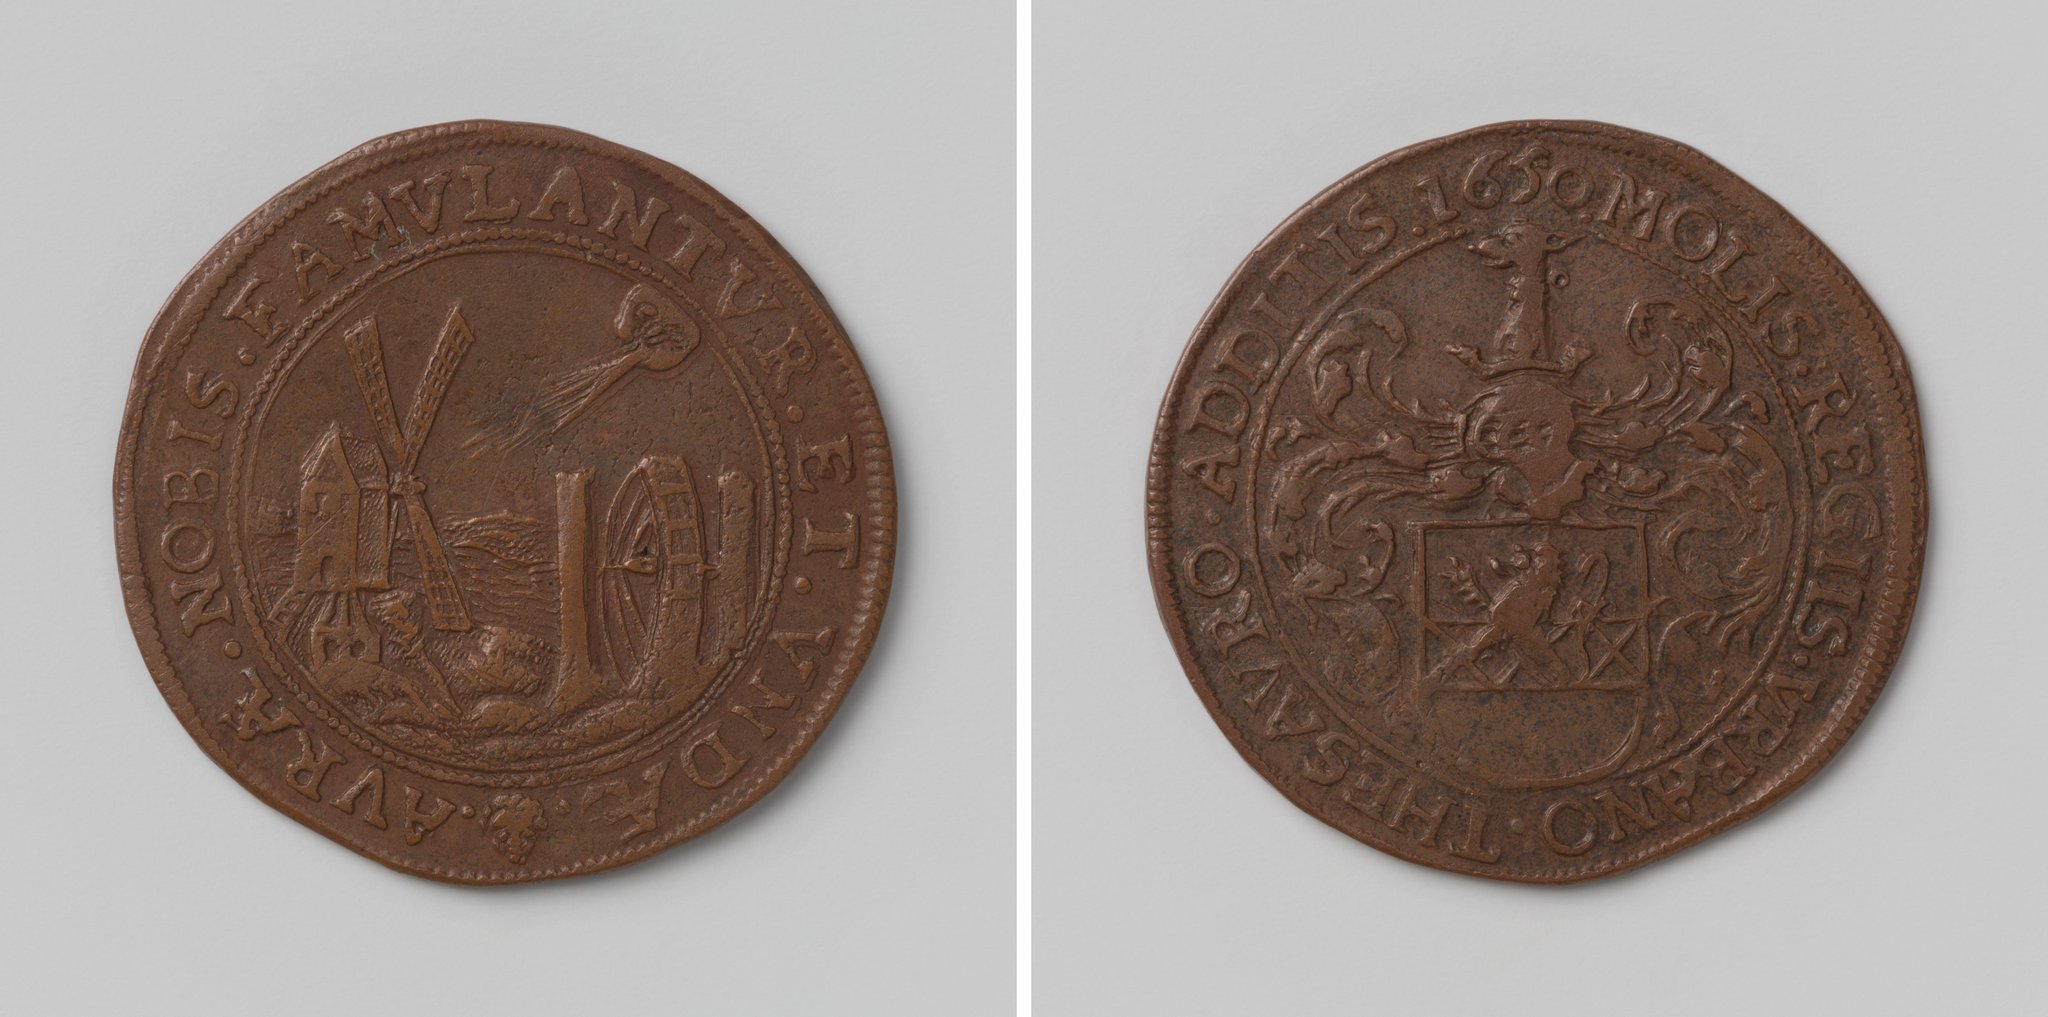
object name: jeton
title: Storten van de koninklijke belasting op molens in de schatkist van de stad Brussel, rekenpenning van Jean Vander Tommen, magistraat van de schatkist van Brussel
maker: Anonymous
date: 1601-1650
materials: copper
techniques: striking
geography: brussels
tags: brussels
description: Koperen penning. Voorzijde: wind- en watermolen binnen omschrift. Keerzijde: gehelmd wapenschild binnen omschrift